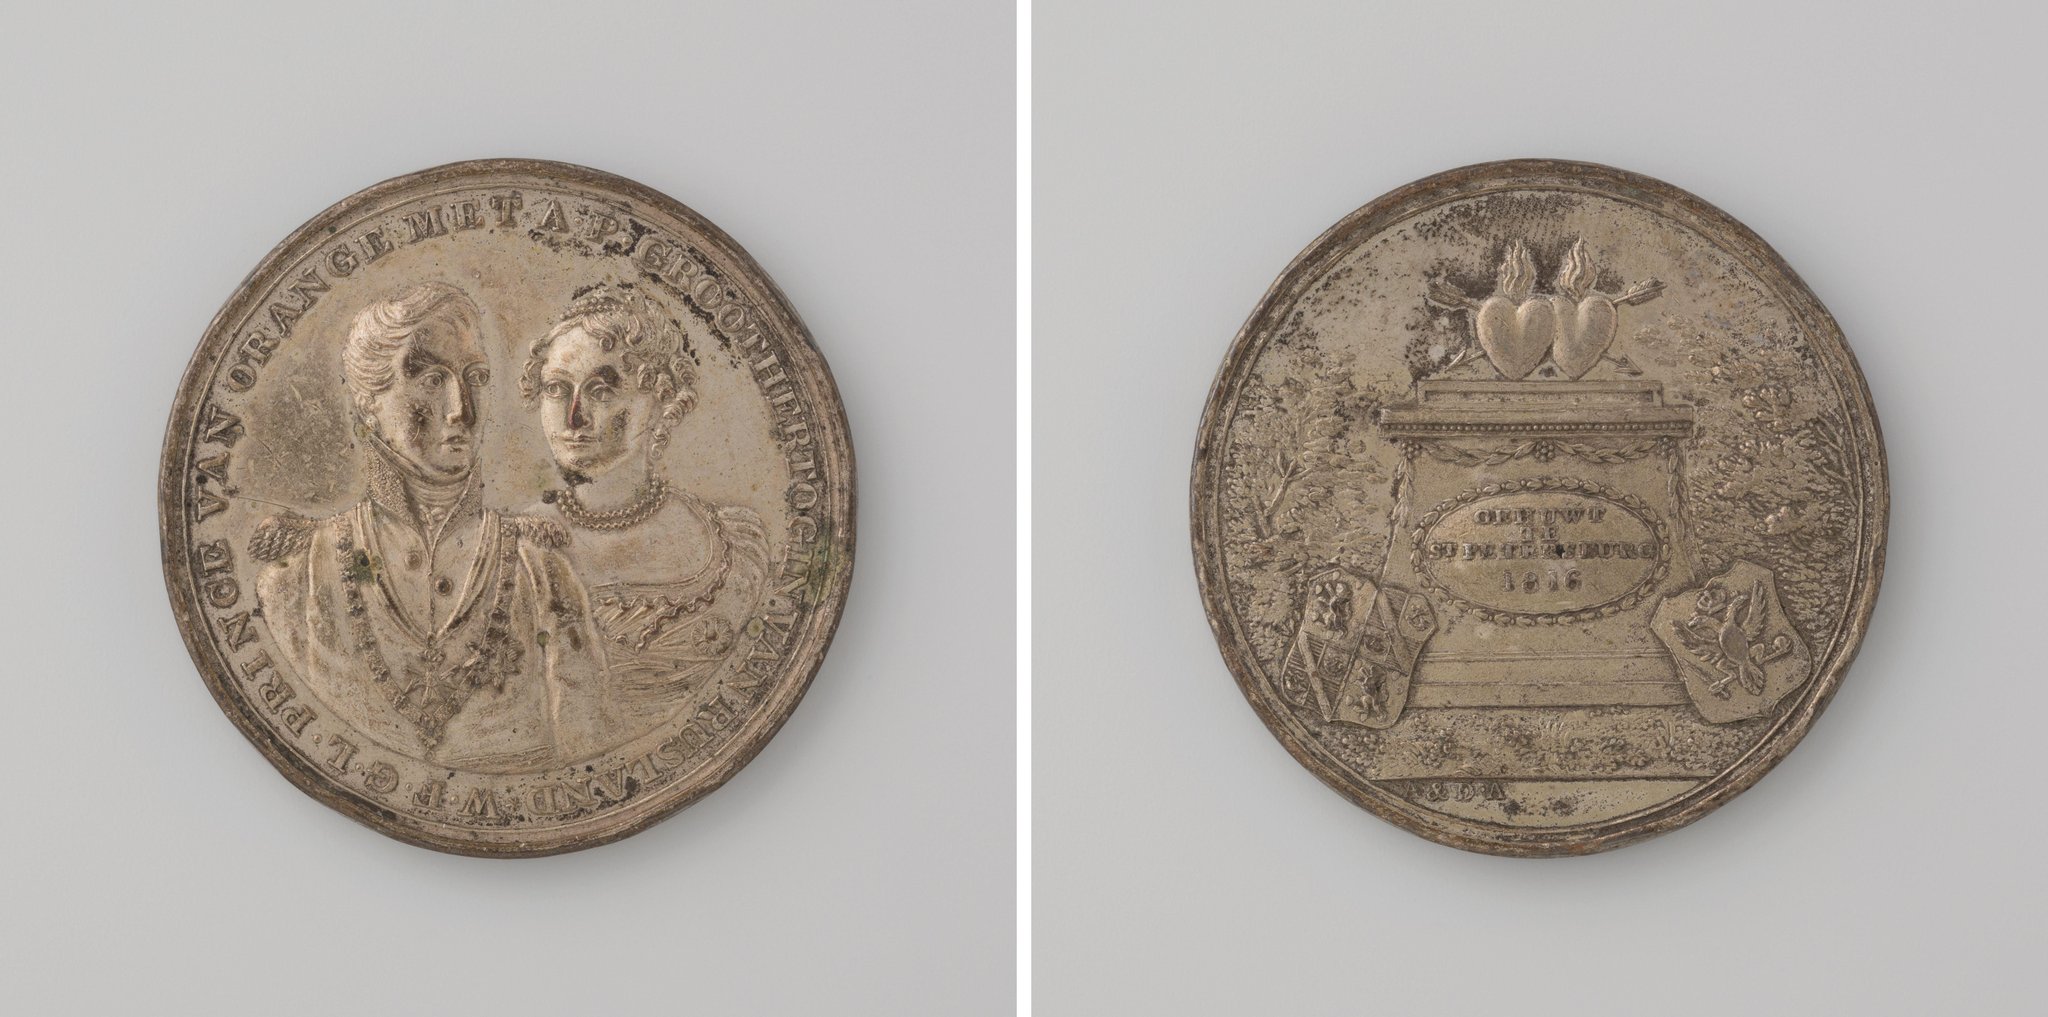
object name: history medal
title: Huwelijk van Willem Frederik George Lodewijk, erfprins der Nederlanden en Anna Paulowna, grootvorstin van Rusland te St. Petersburg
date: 1816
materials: silver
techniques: striking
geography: netherlands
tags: anna paulowna romanowa, william ii of the netherlands